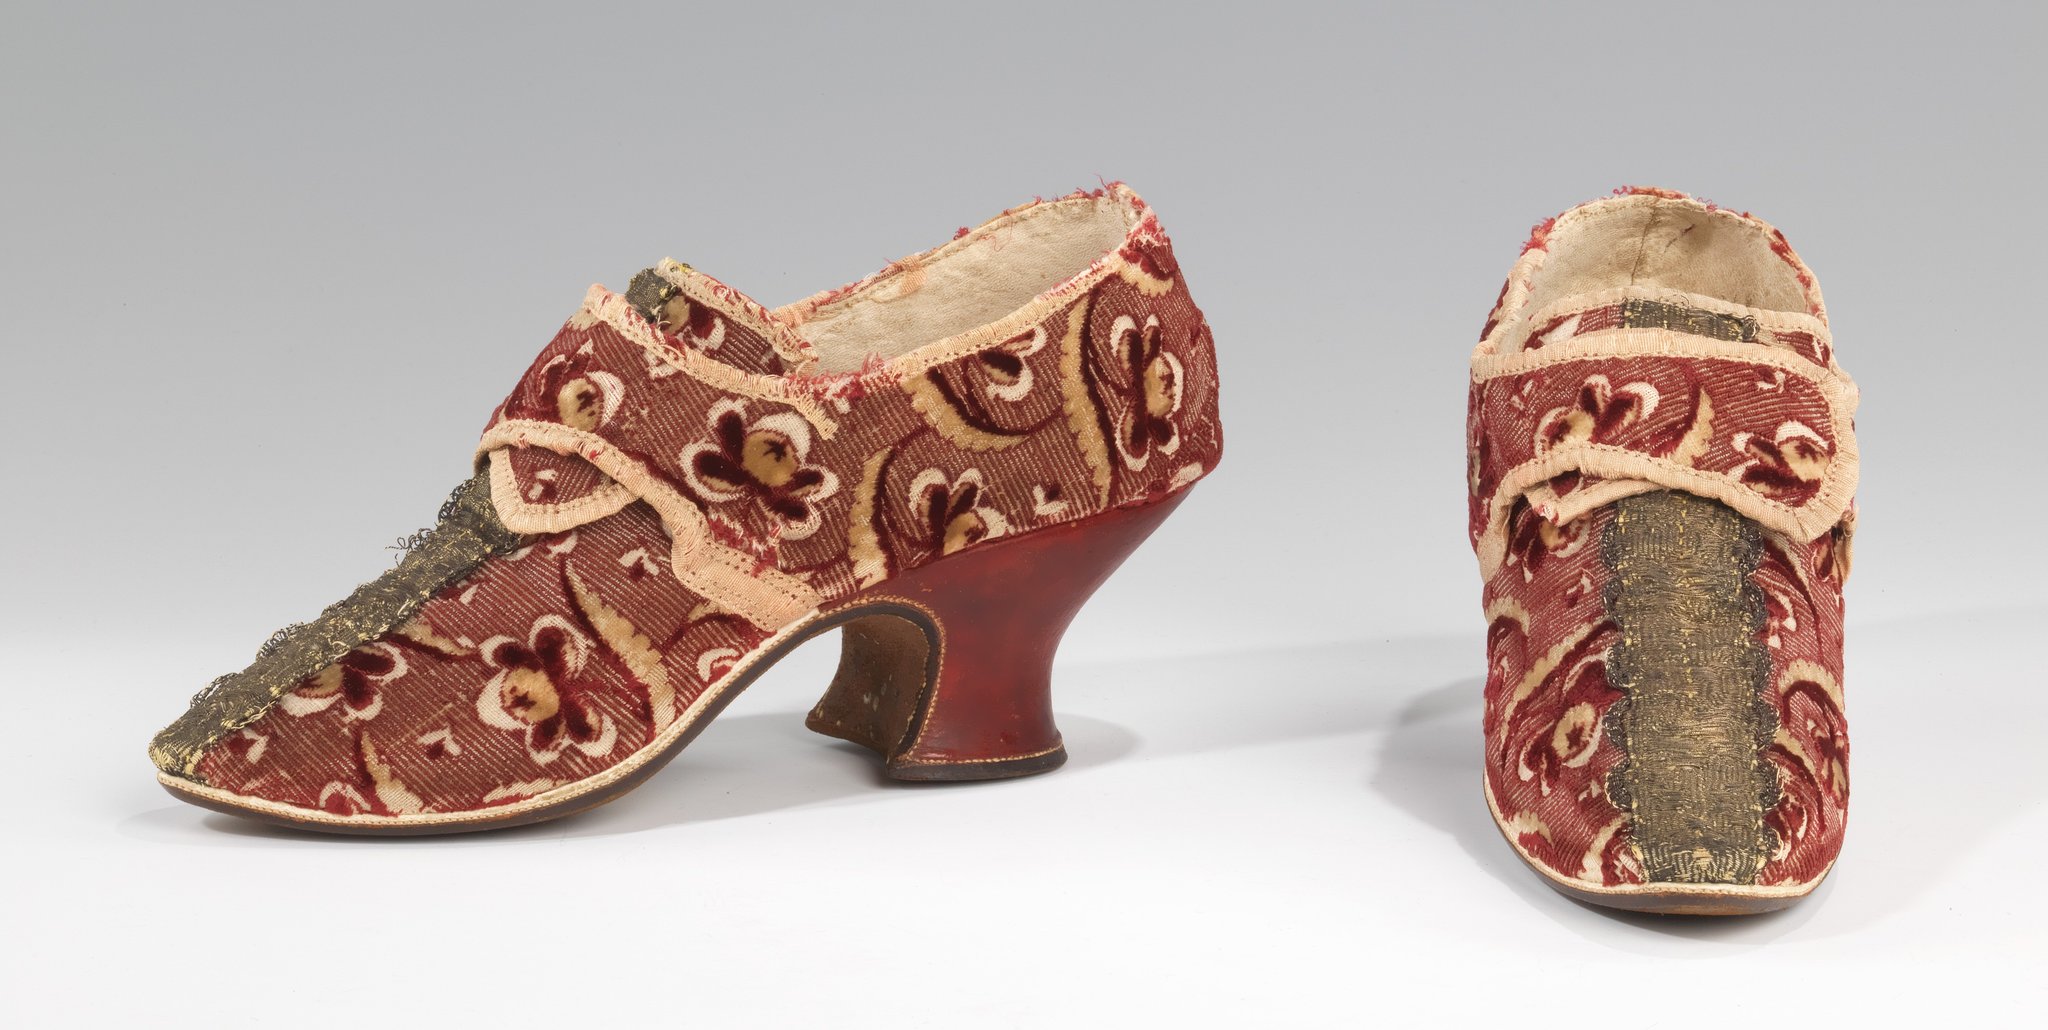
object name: shoe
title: Shoes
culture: british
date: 1732-1759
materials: leather, metal, silk